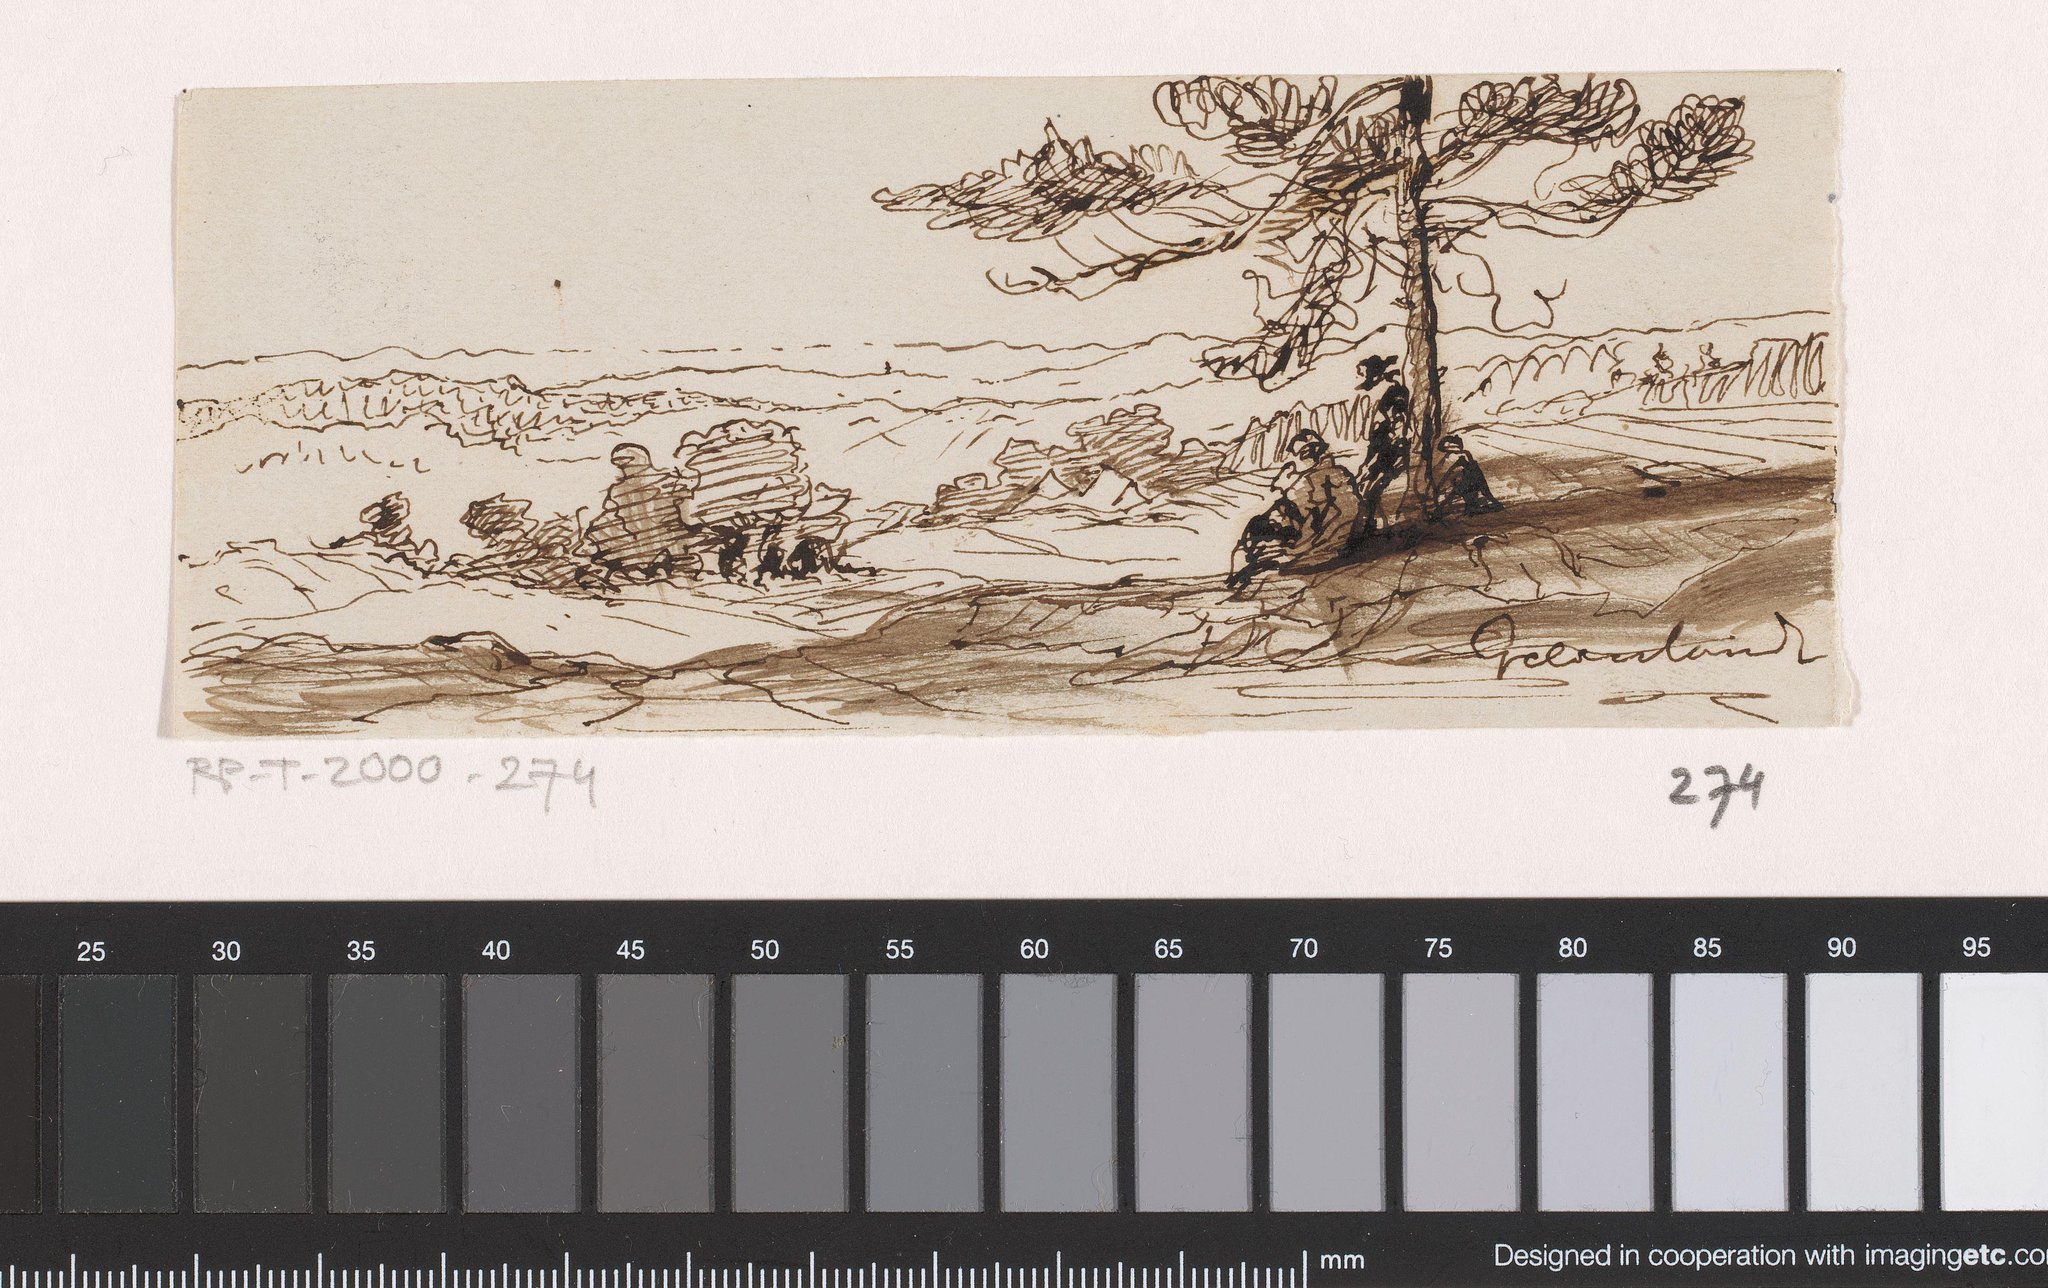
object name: drawing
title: Gelders landschap met rustende jagers onder een boom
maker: johannes tavenraat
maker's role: draughtsman, painter, print maker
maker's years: 1809-1881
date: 1840-1880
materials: ink, paper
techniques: brush, pen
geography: gelderland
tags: low hill country, hunters resting during the hunt, gelderland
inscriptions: annotation: ‘Gelderland’, collector's mark: Lugt 2228